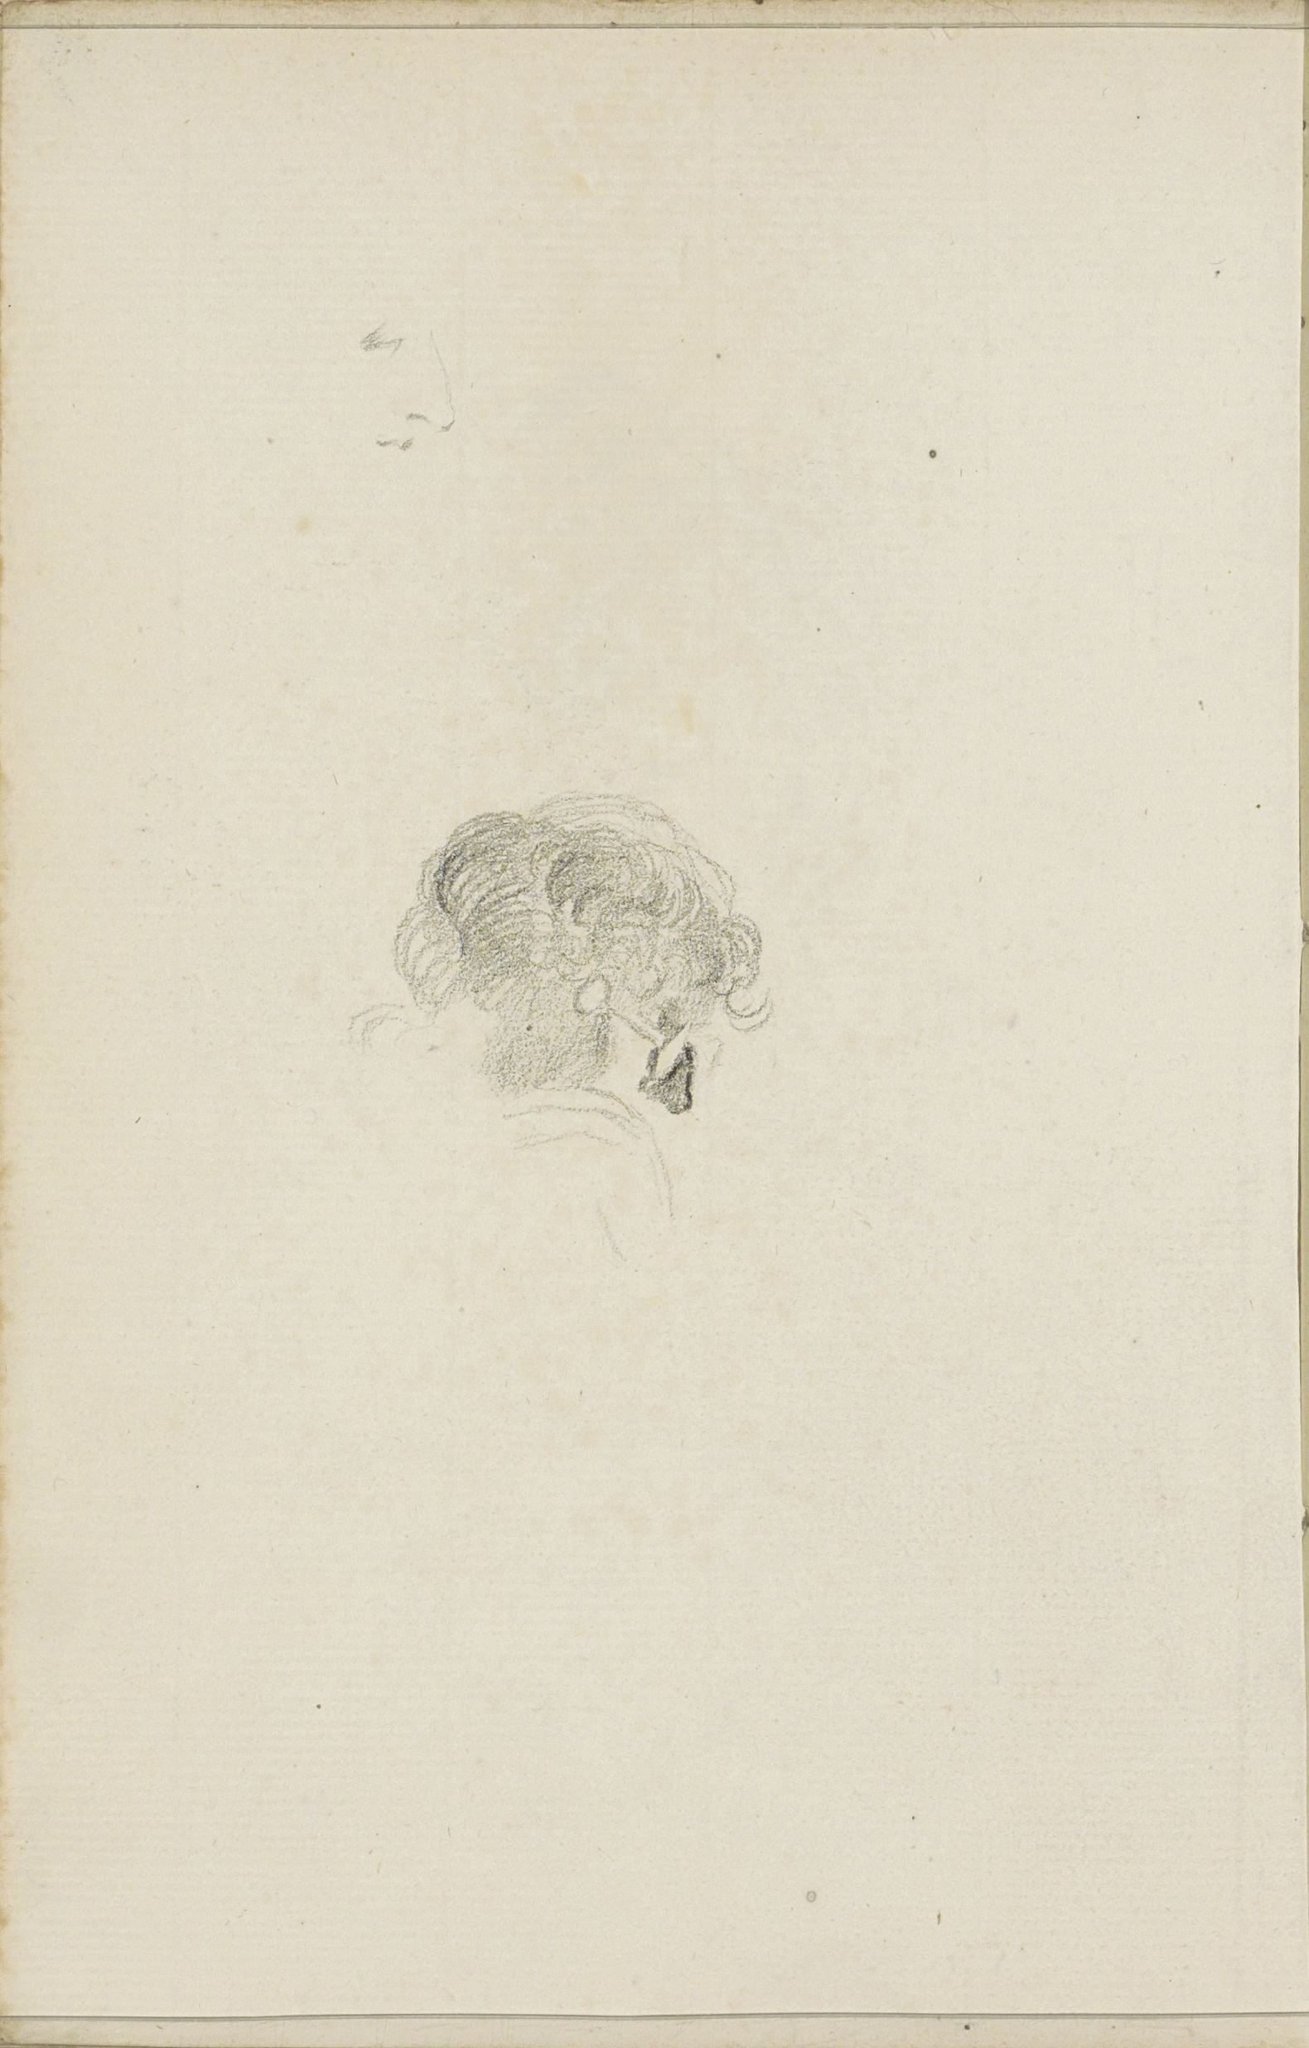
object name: sketchbook leaf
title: Achterhoofd van een man met krullend haar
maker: jacob perkois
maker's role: draughtsman, print maker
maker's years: 1756-1804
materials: paper, pencil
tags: head (human)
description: Tevens een studie van een gezicht in profiel naar rechts. Bladzijde 58 uit een schetsboek met 78 bladzijden.